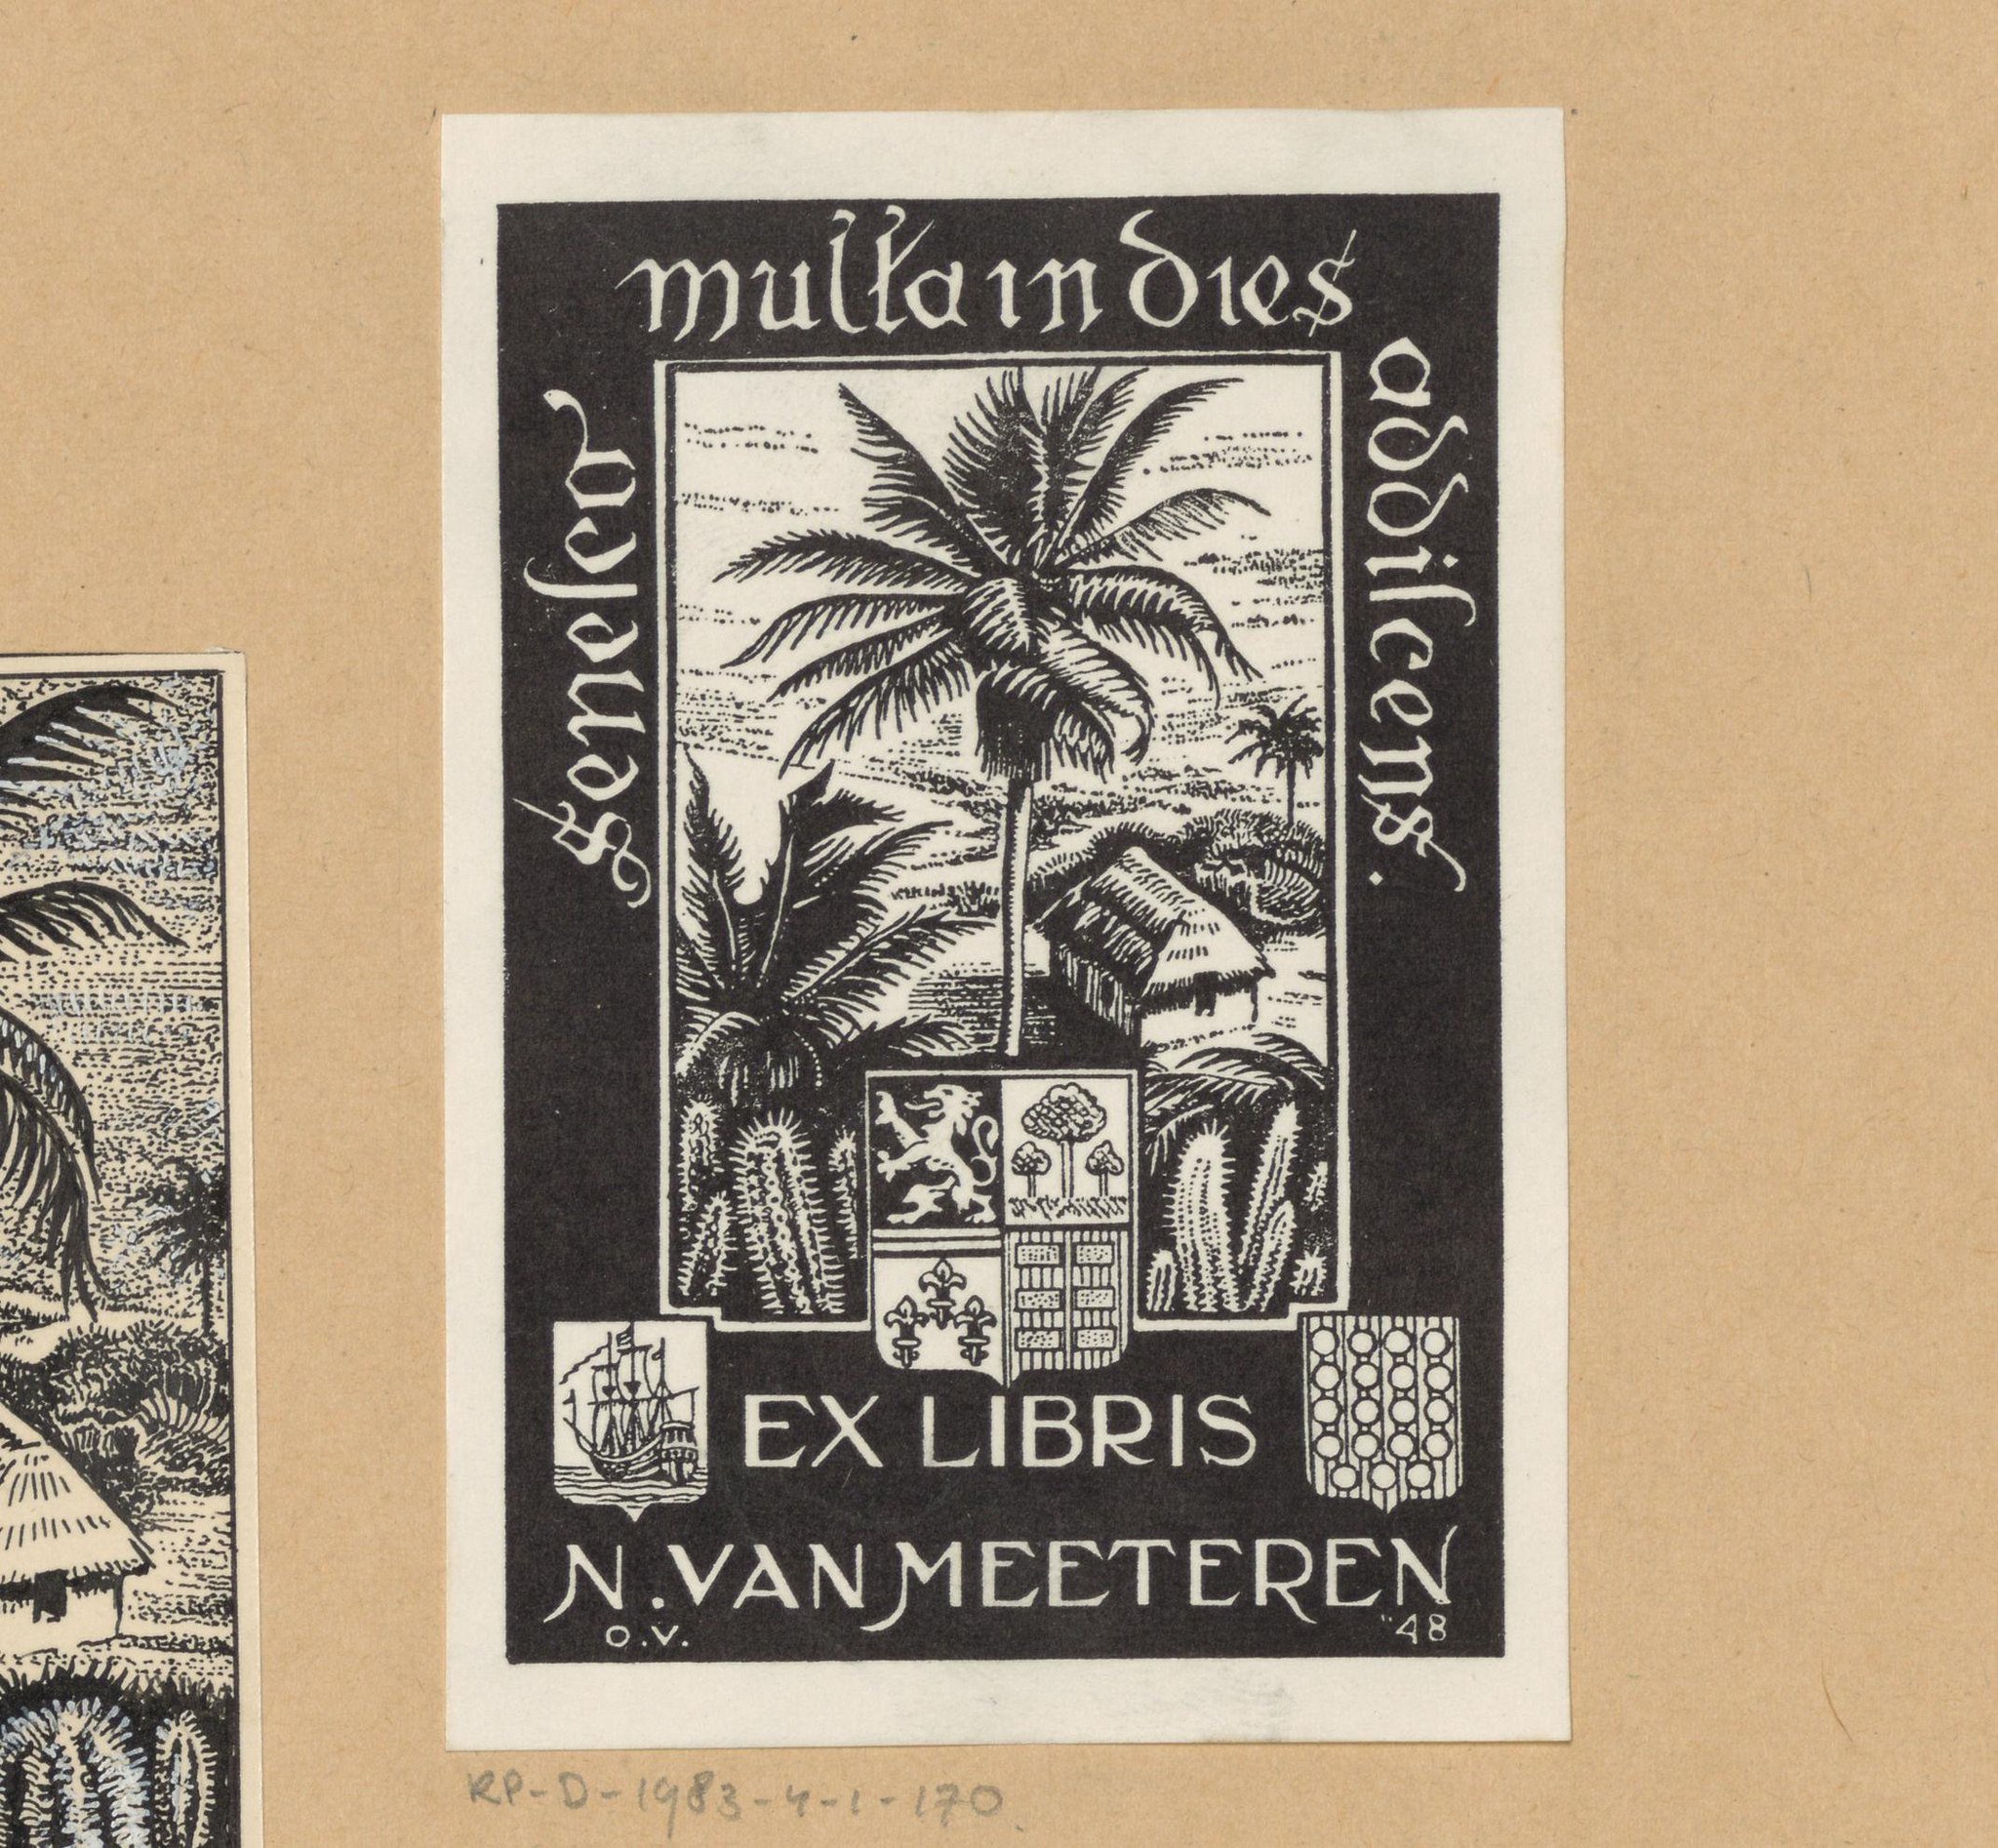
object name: bookplate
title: Ex libris van N. van Meeteren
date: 1948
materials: paper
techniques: printing block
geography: netherlands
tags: sailing-ship, sailing-boat, trees: palm-tree, hut, cabin, lodge, armorial bearing, heraldry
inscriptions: inscription: ‘Cliché naar pentekening (...) wapen Geldermalsen (rechts)’, inscription: ‘2e afdruk randschrift verbeterd/ familiewapen verbeterd’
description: De wapens van Curaçao, Geldermalsen en de familie Van Meeteren zijn verbeeld.